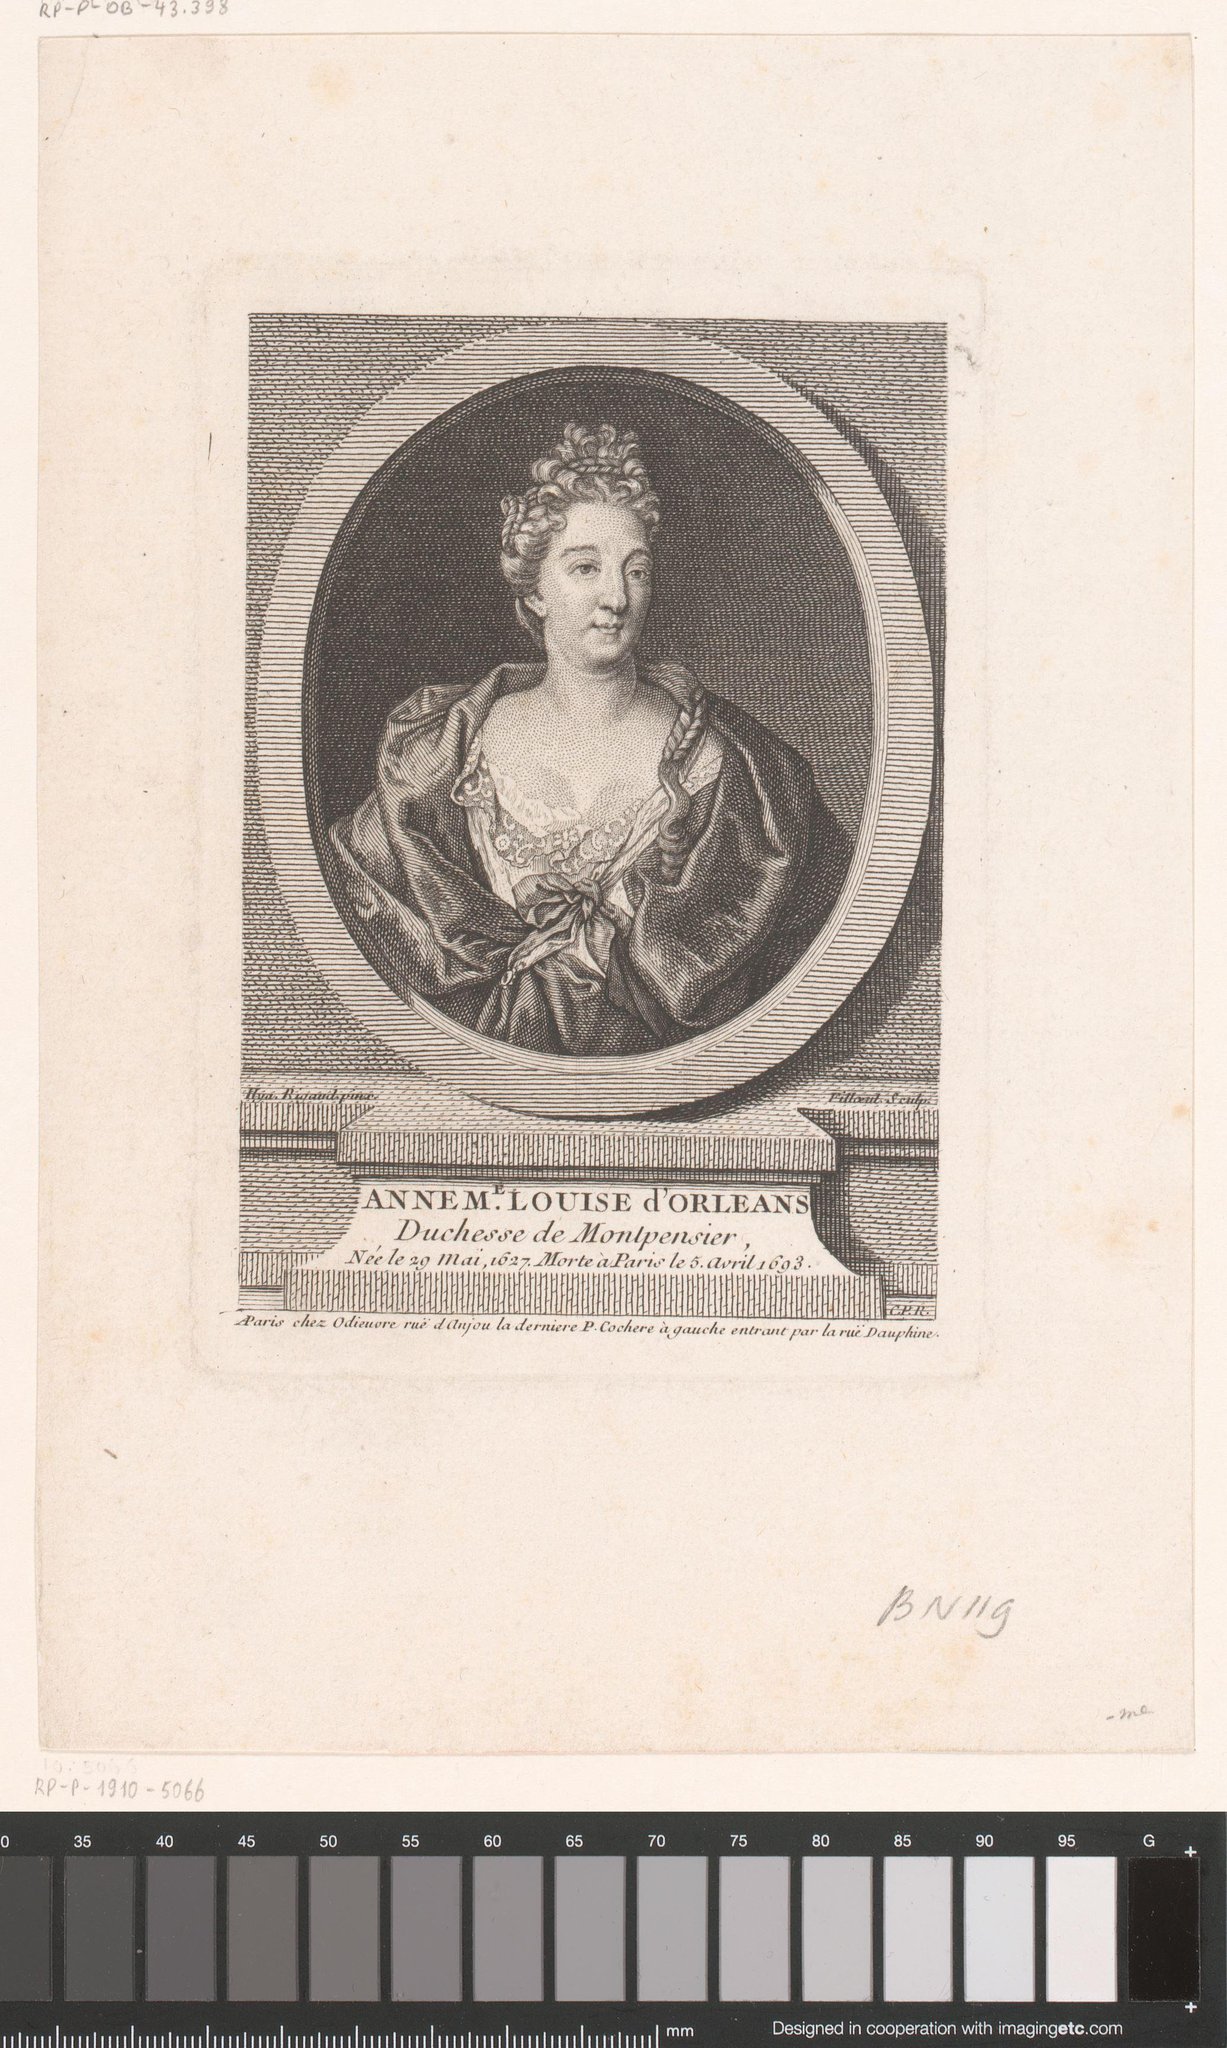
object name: print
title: Annem.e Louise d'Orleans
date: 1744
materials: paper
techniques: engraving, etching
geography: paris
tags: anne marie louise d' orléans (hertogin van montpensier), historical persons - bb - woman, ornament ~ medallion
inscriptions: collector's mark: Lugt 2228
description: Prent uit: Dreux du Radier, Jean-François. L'Europe illustré, contenant l'histoire abregée des souverains, des princes, des prélats, des ministres, (...) en Europe: dans le XVe. siècle compris, jusqu'à présent. Parijs: Michel Odieuvre en Jean-Luc Nyon, 1755, dl. 2.